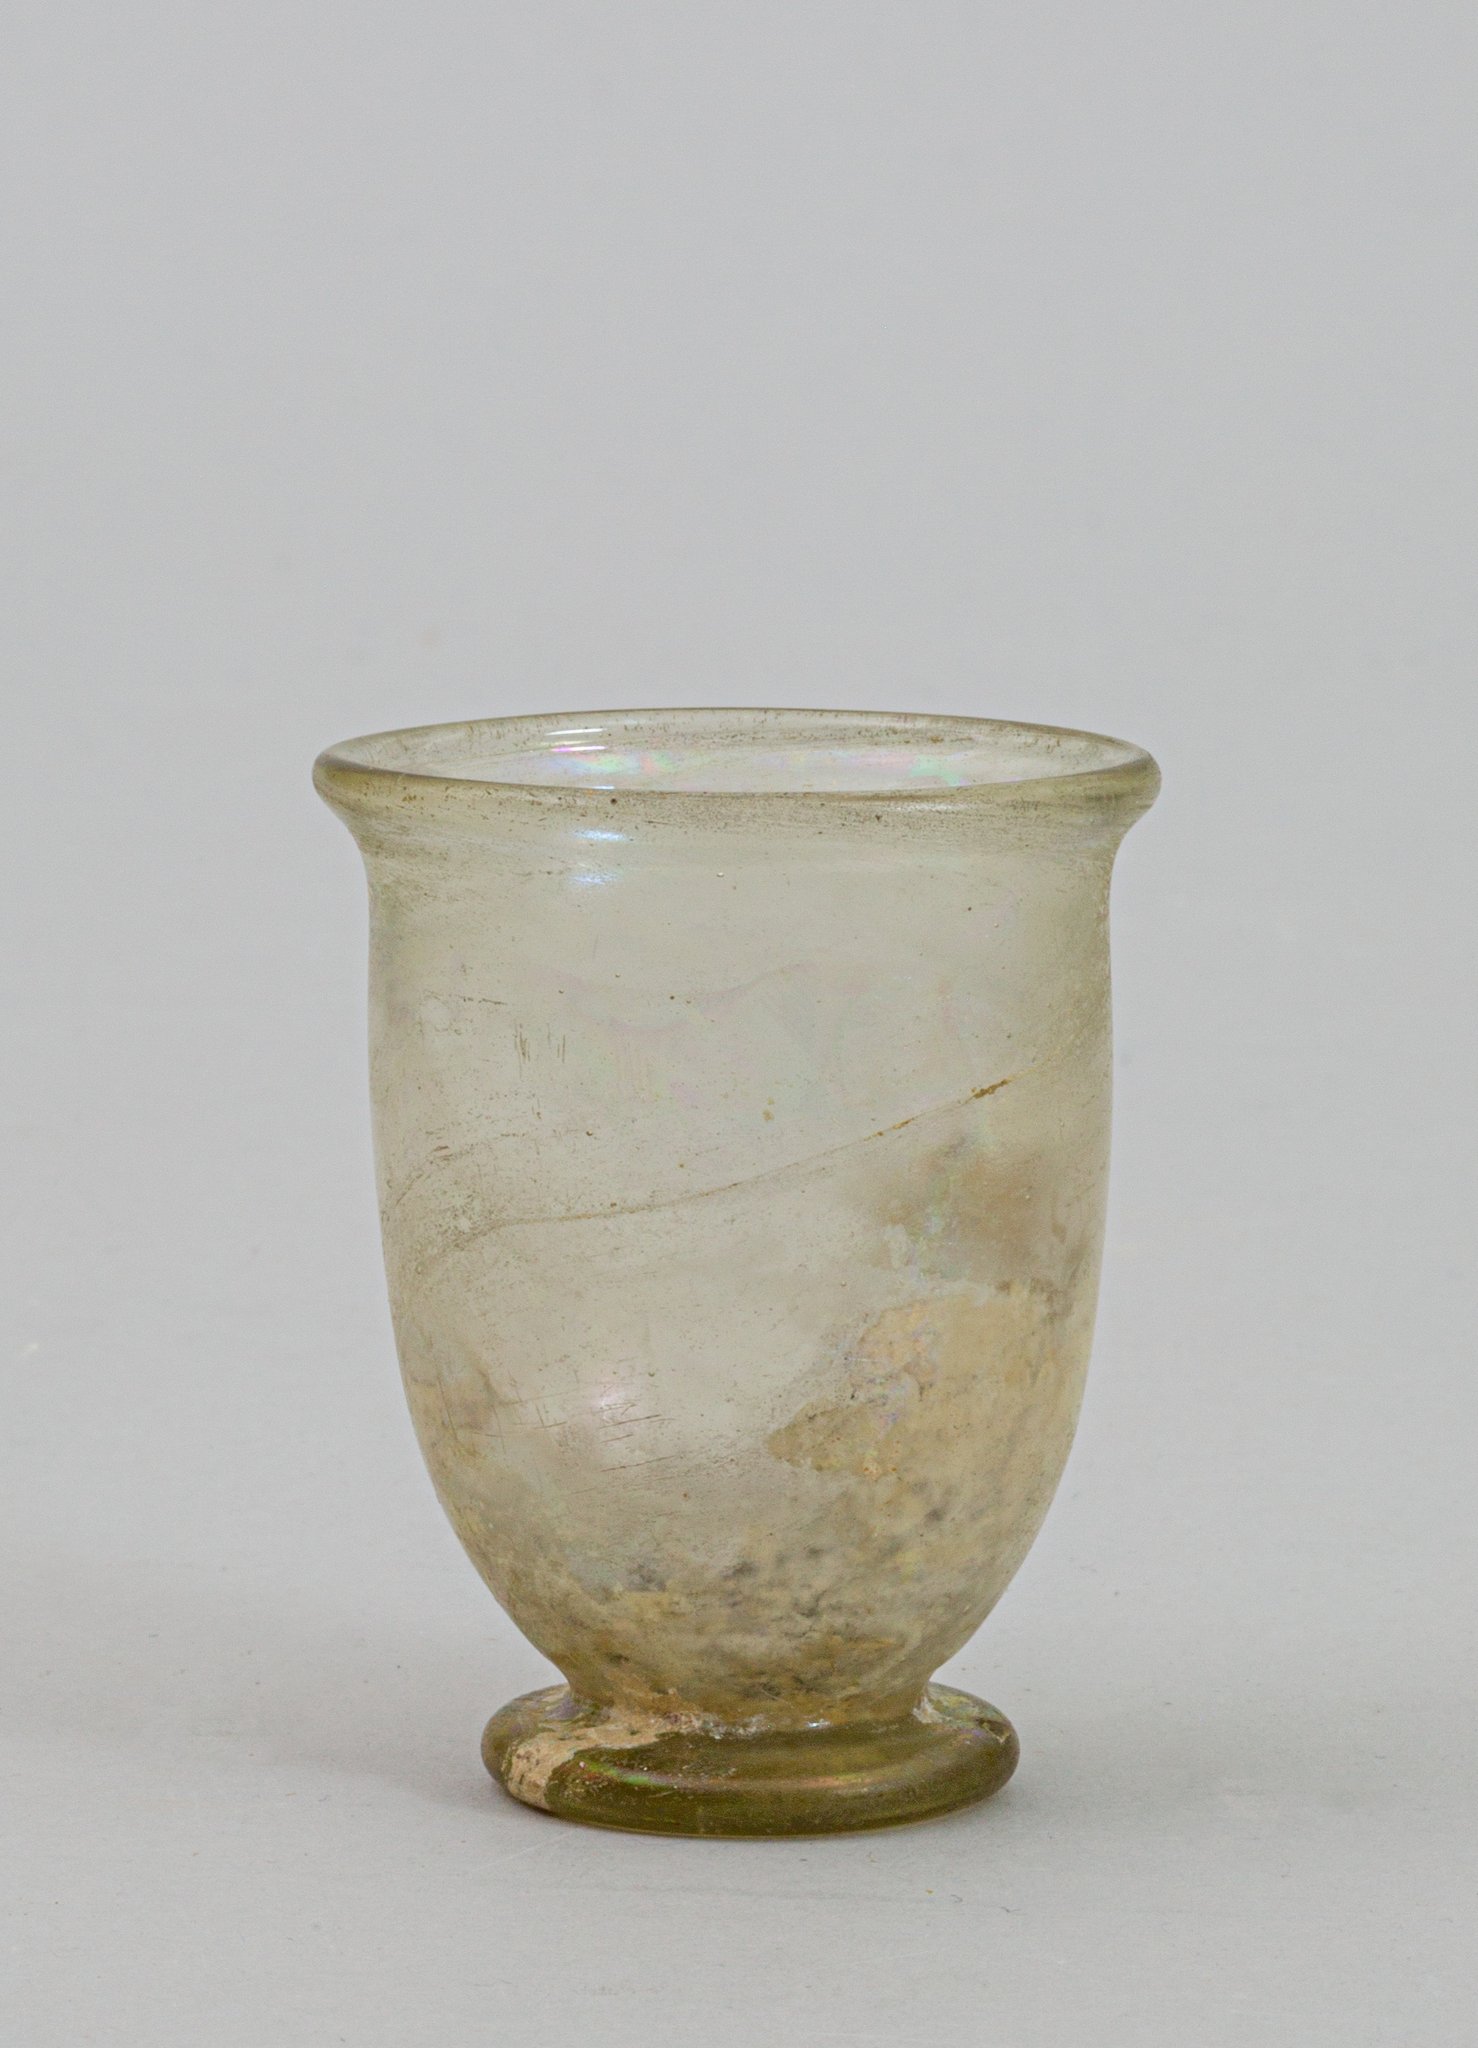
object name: cup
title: Glass cup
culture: roman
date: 201-400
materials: glass